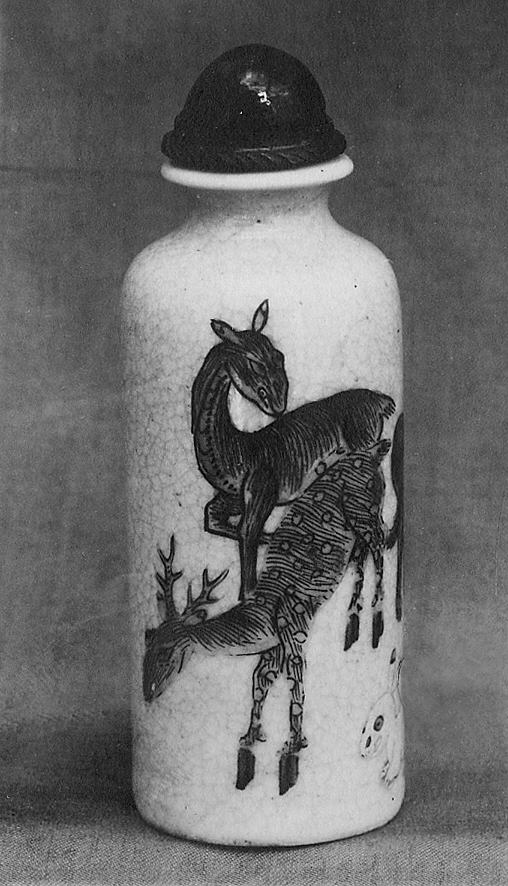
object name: snuff bottle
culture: chinese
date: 1821-1850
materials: porcelain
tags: deer